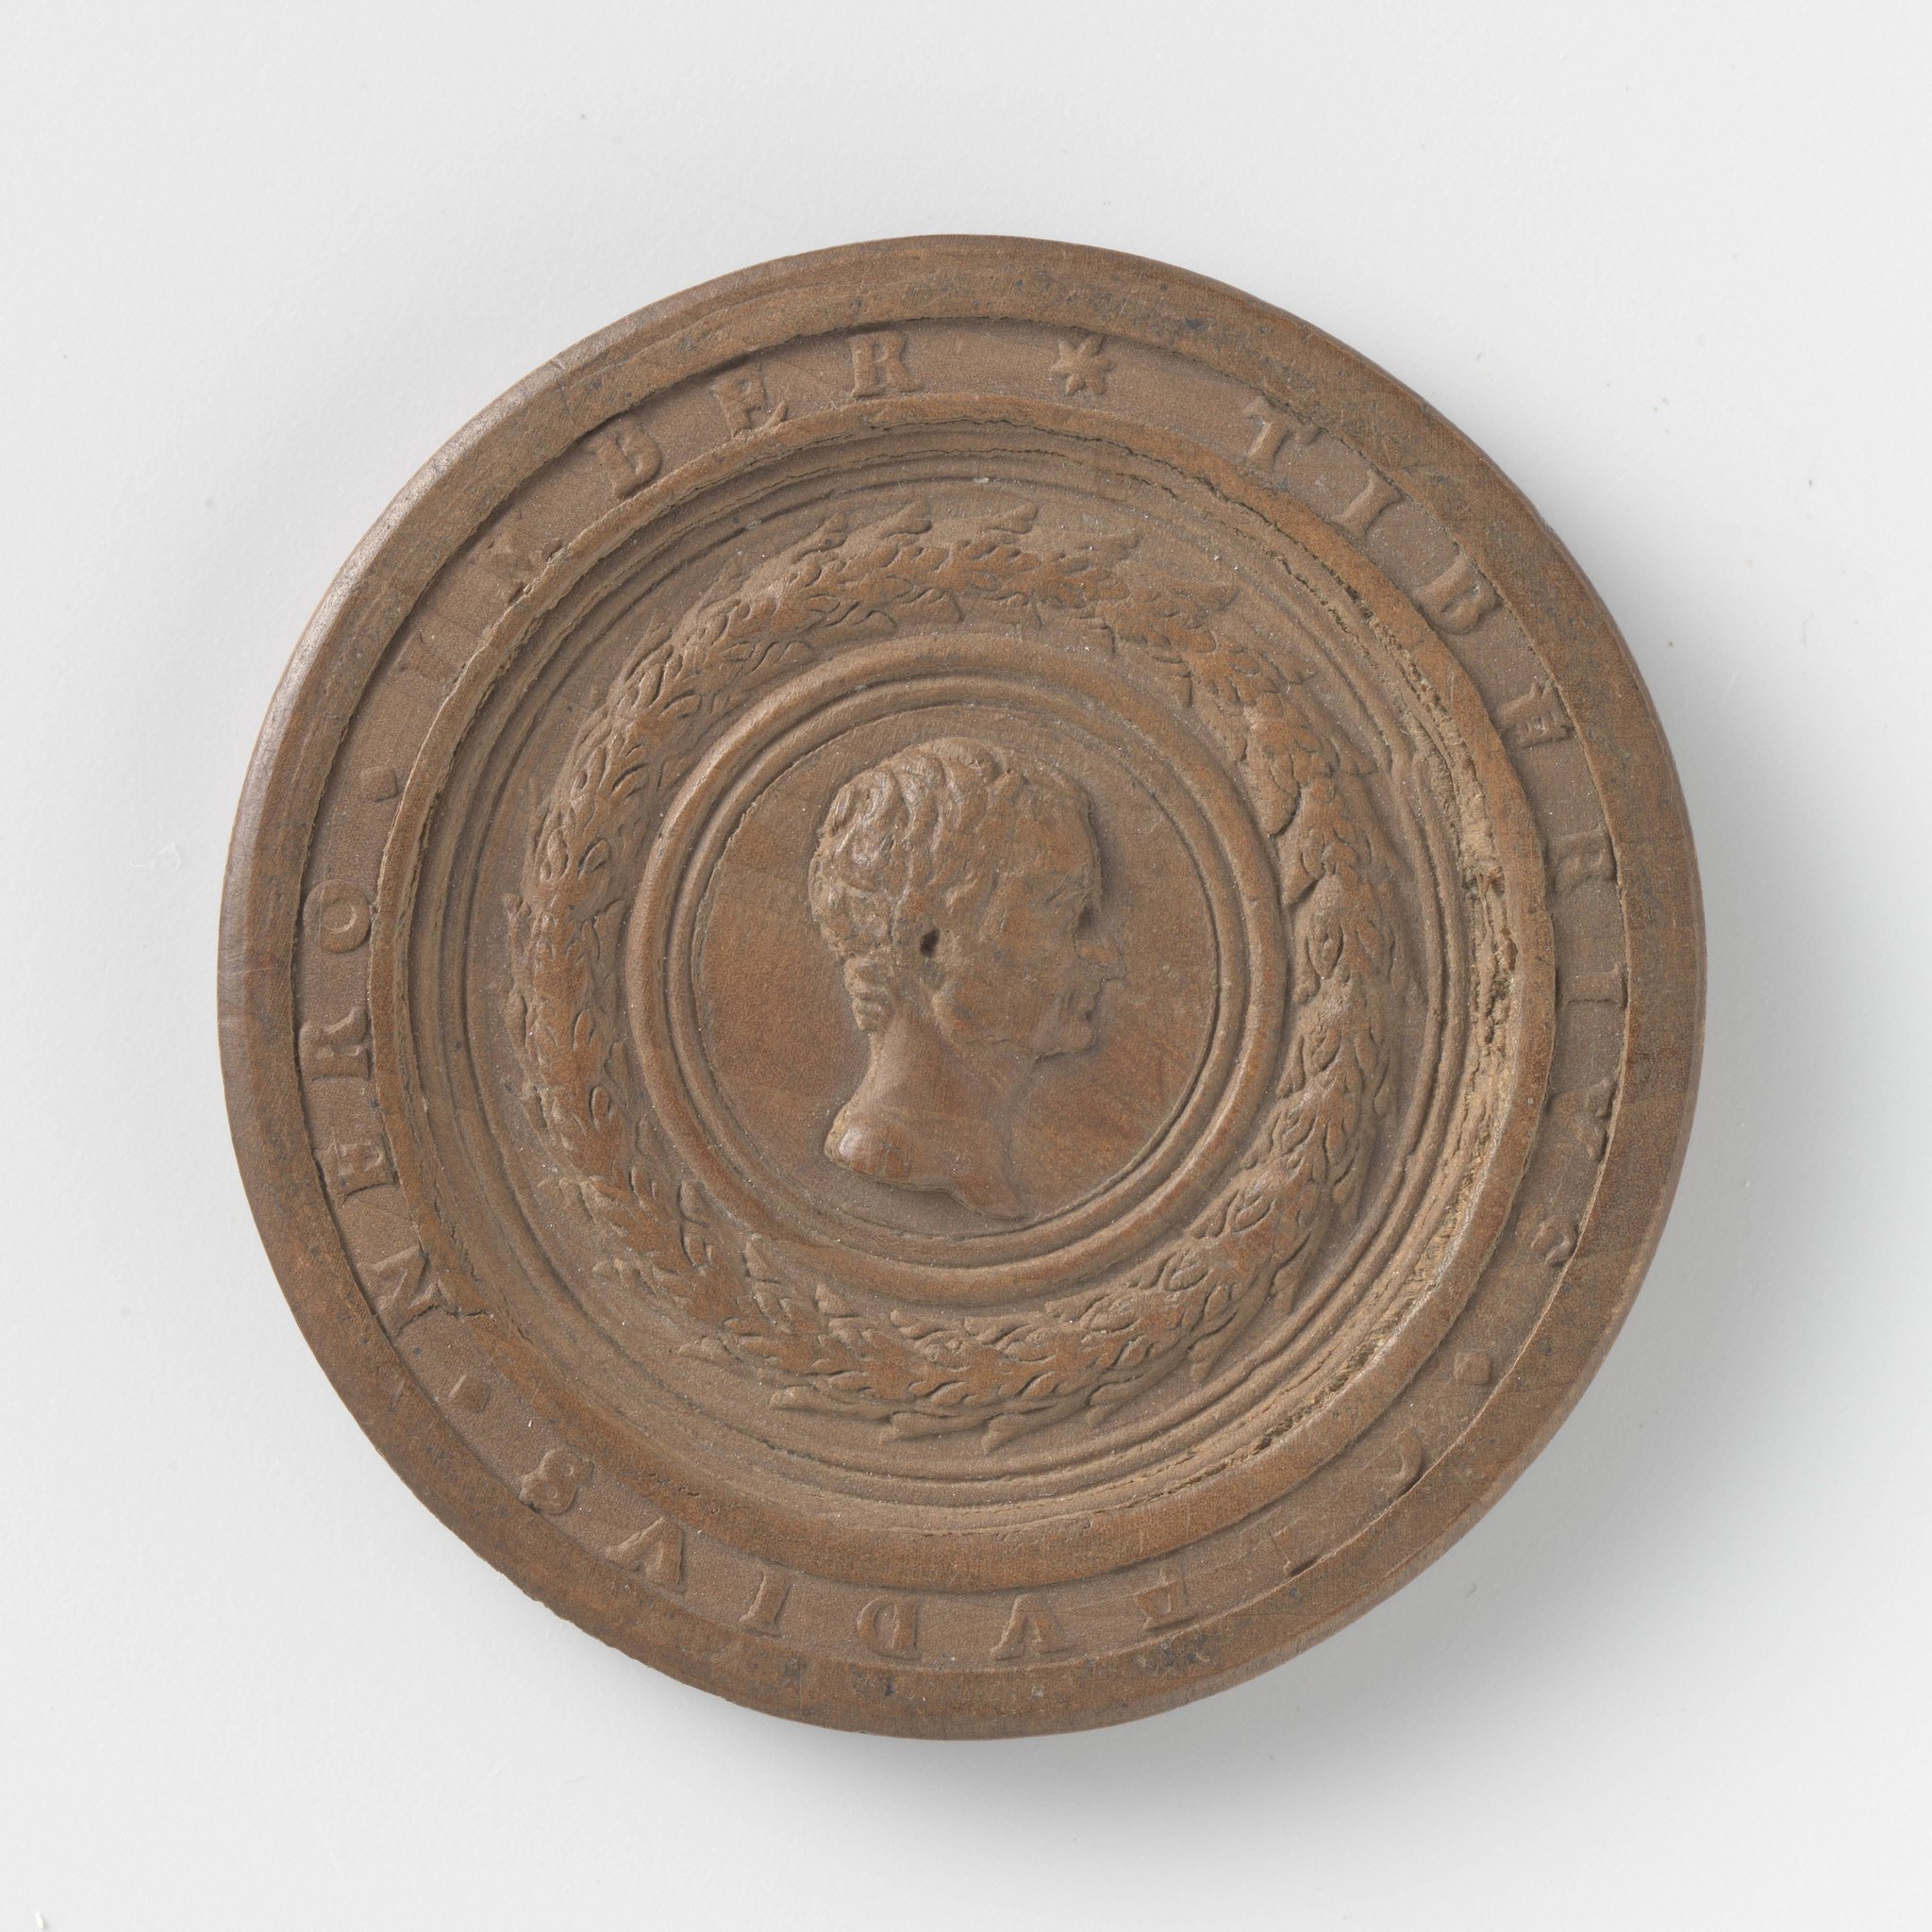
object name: checker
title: Helft van damschijf met portret: Tiberius Claudius Nero Germanicus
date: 1525-1575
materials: wood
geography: nuremberg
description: TIBERIVS. CLAUDIUS. NERO. IMBER (Tiberius Claudius Nero Germanicus, Romeins keizer van 14-37)